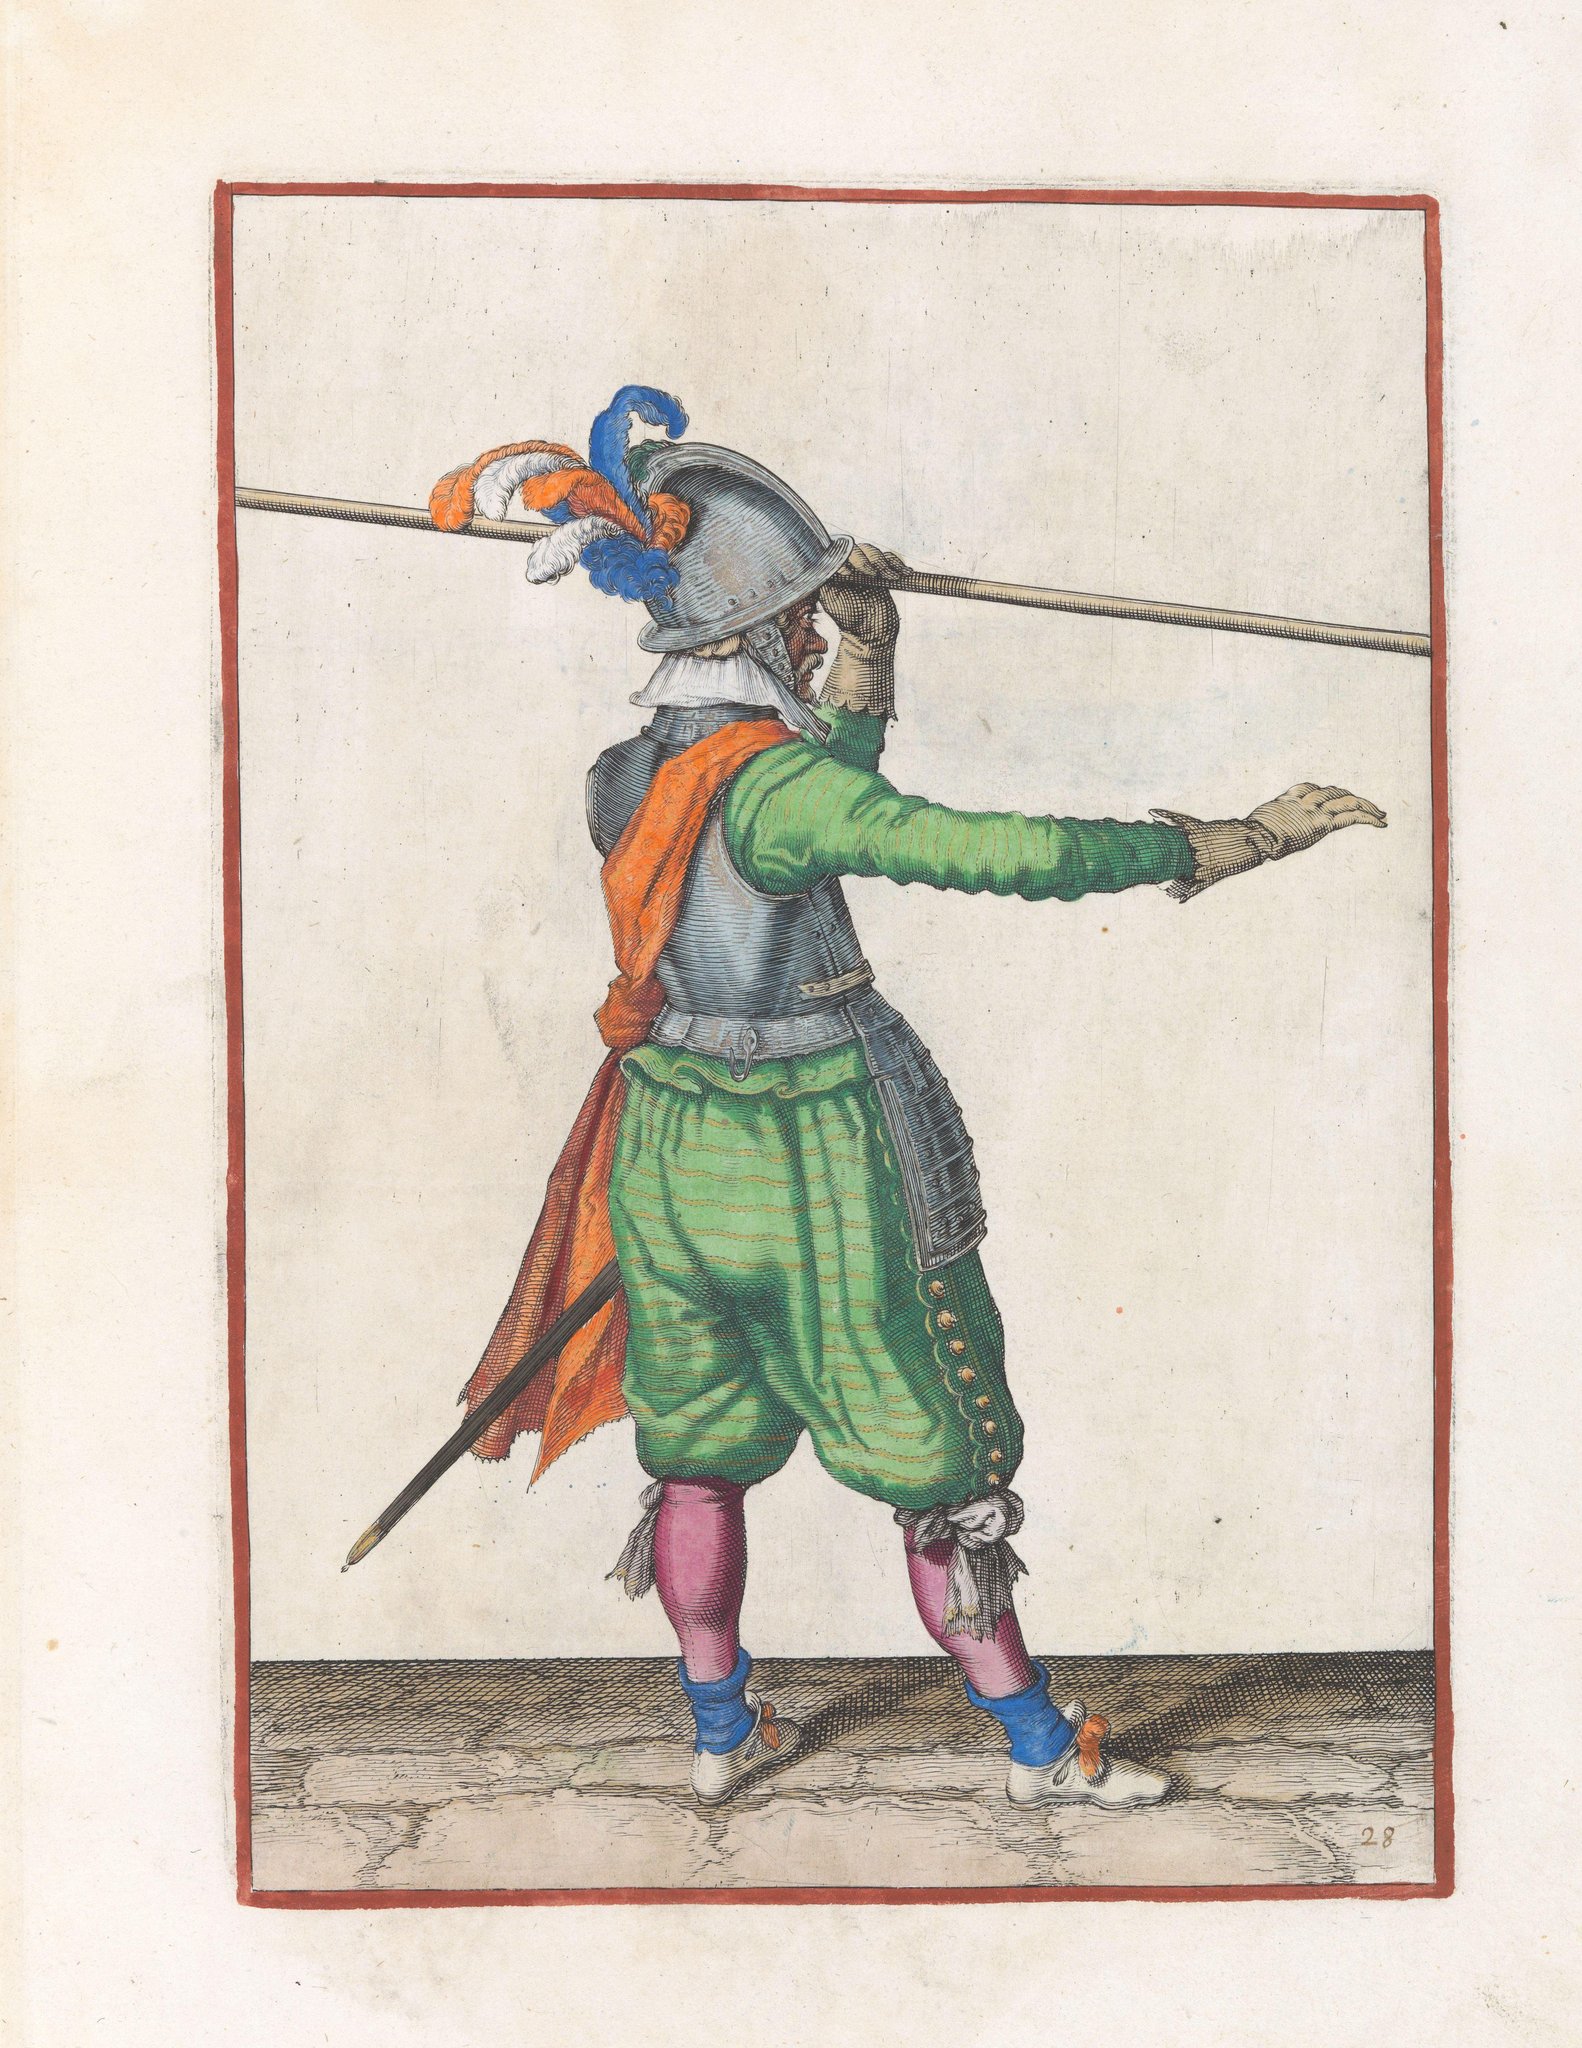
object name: print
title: Soldaat die zijn spies met zijn linkerhand boven zijn linkerschouder draagt, zijn rechterhand uitgestrekt naar voren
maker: jacques de gheyn (ii)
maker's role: painter, print maker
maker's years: 1565-1629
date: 1597-1607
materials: paper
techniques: engraving, hand coloring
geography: the hague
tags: handling of weapons ~ military training, helved weapons, polearms (for striking, hacking, thrusting): lance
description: Een soldaat, ten voeten uit, naar rechts, die een spies (lans) met zijn linkerhand boven zijn linkerschouder draagt, zijn rechterhand uitgestrekt naar voren. Deze prent is onderdeel van de reeks van 32 met de hand genummerde prenten van spiesdragers in de Wapenhandelinghe.